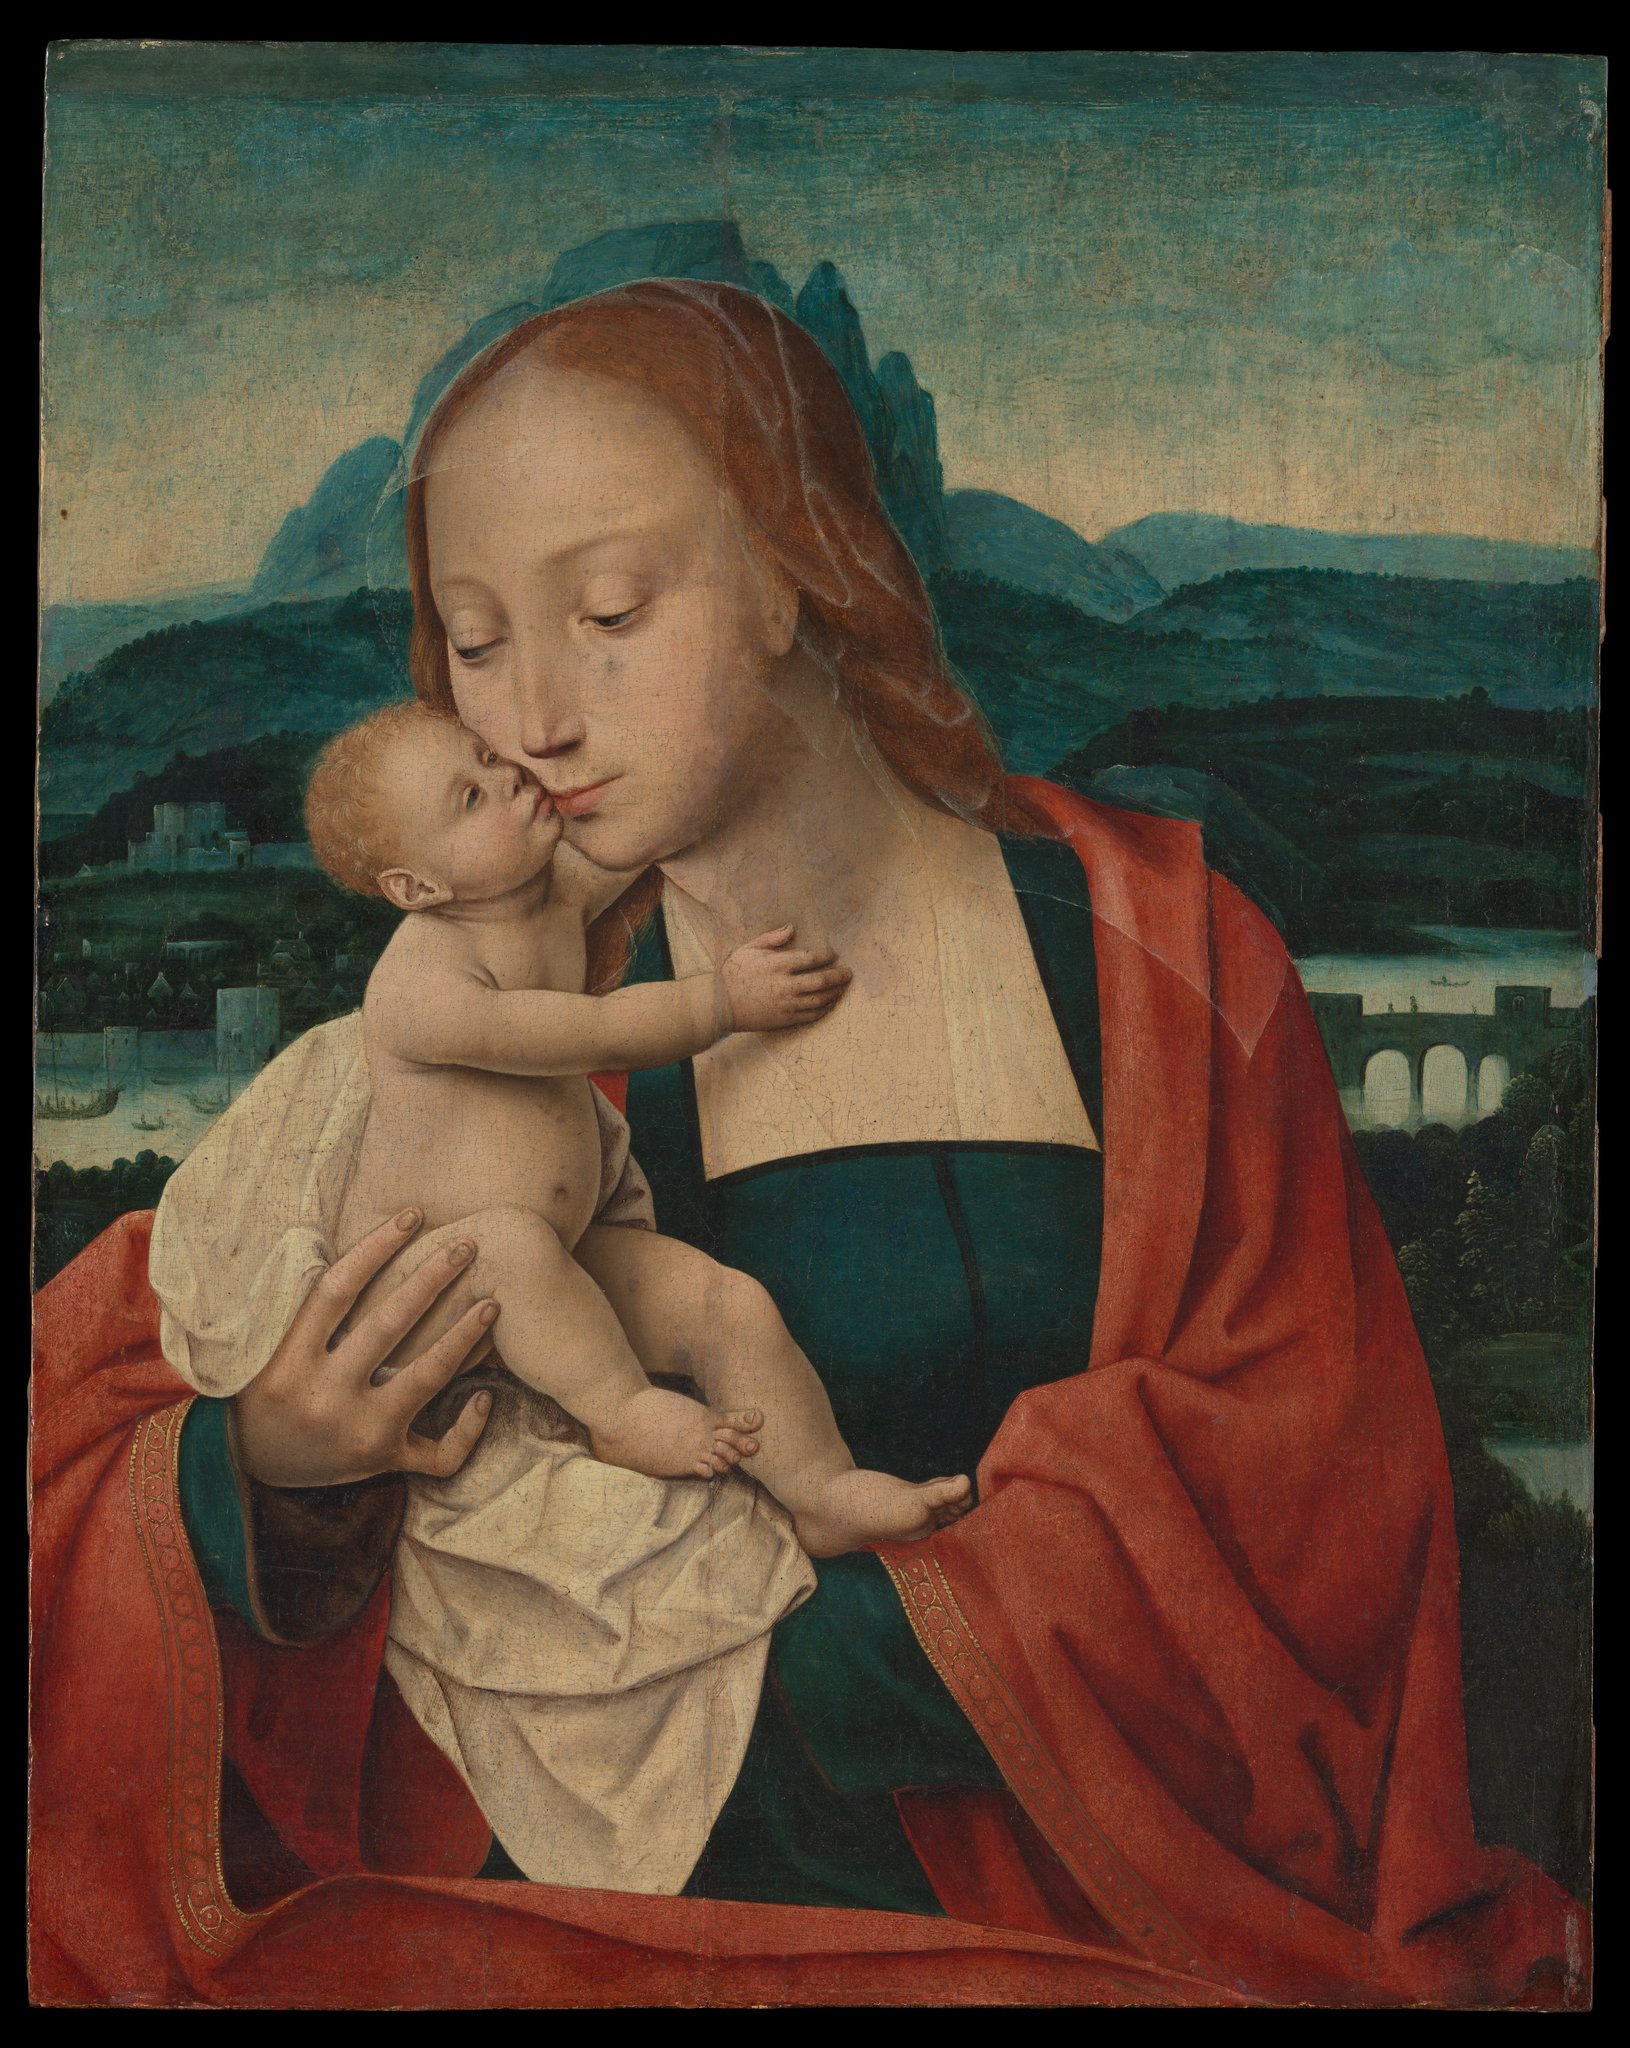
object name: painting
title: Virgin and Child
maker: master of the mansi magdalen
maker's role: artist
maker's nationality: netherlandish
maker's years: 1500-1524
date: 1500-1524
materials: oil, wood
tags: madonna and child